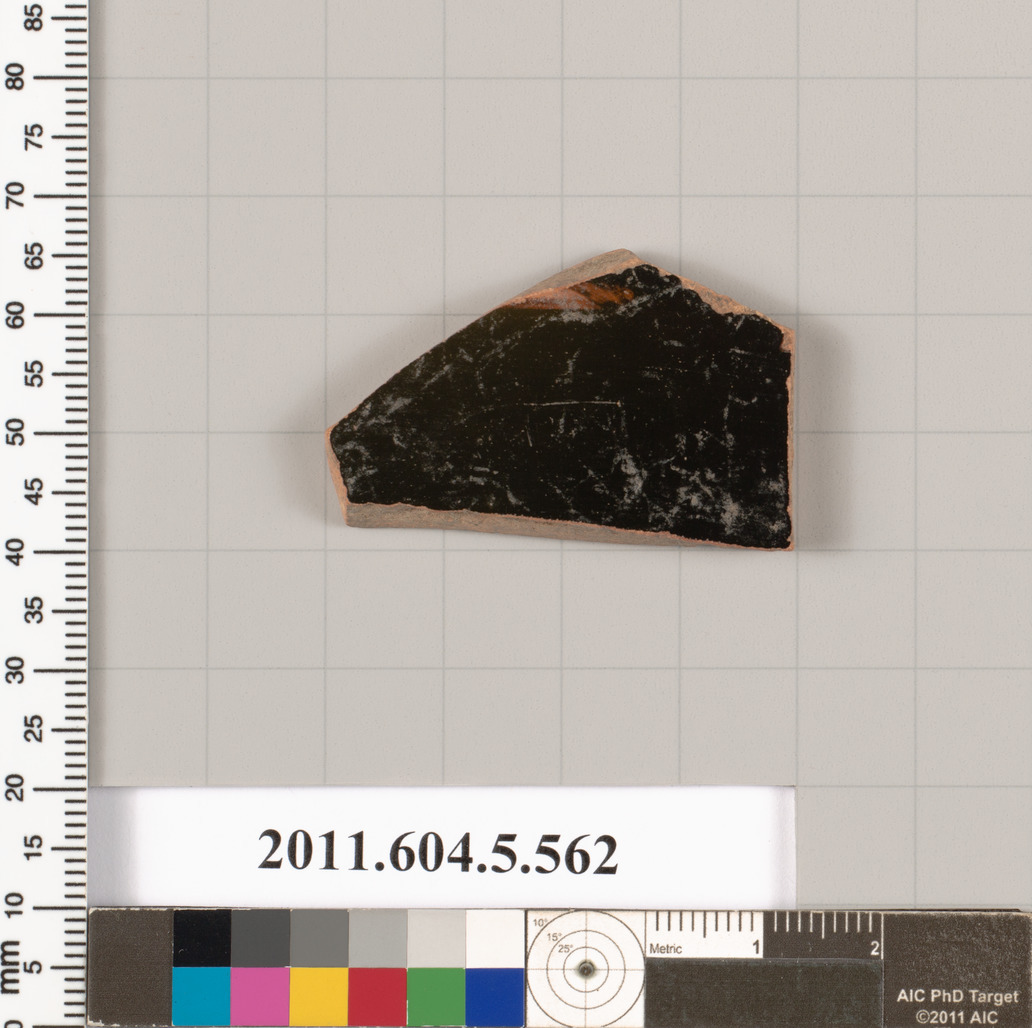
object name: kylix fragment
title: Terracotta fragment of a kylix (drinking cup)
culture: greek, attic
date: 600-401 BCE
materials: terracotta